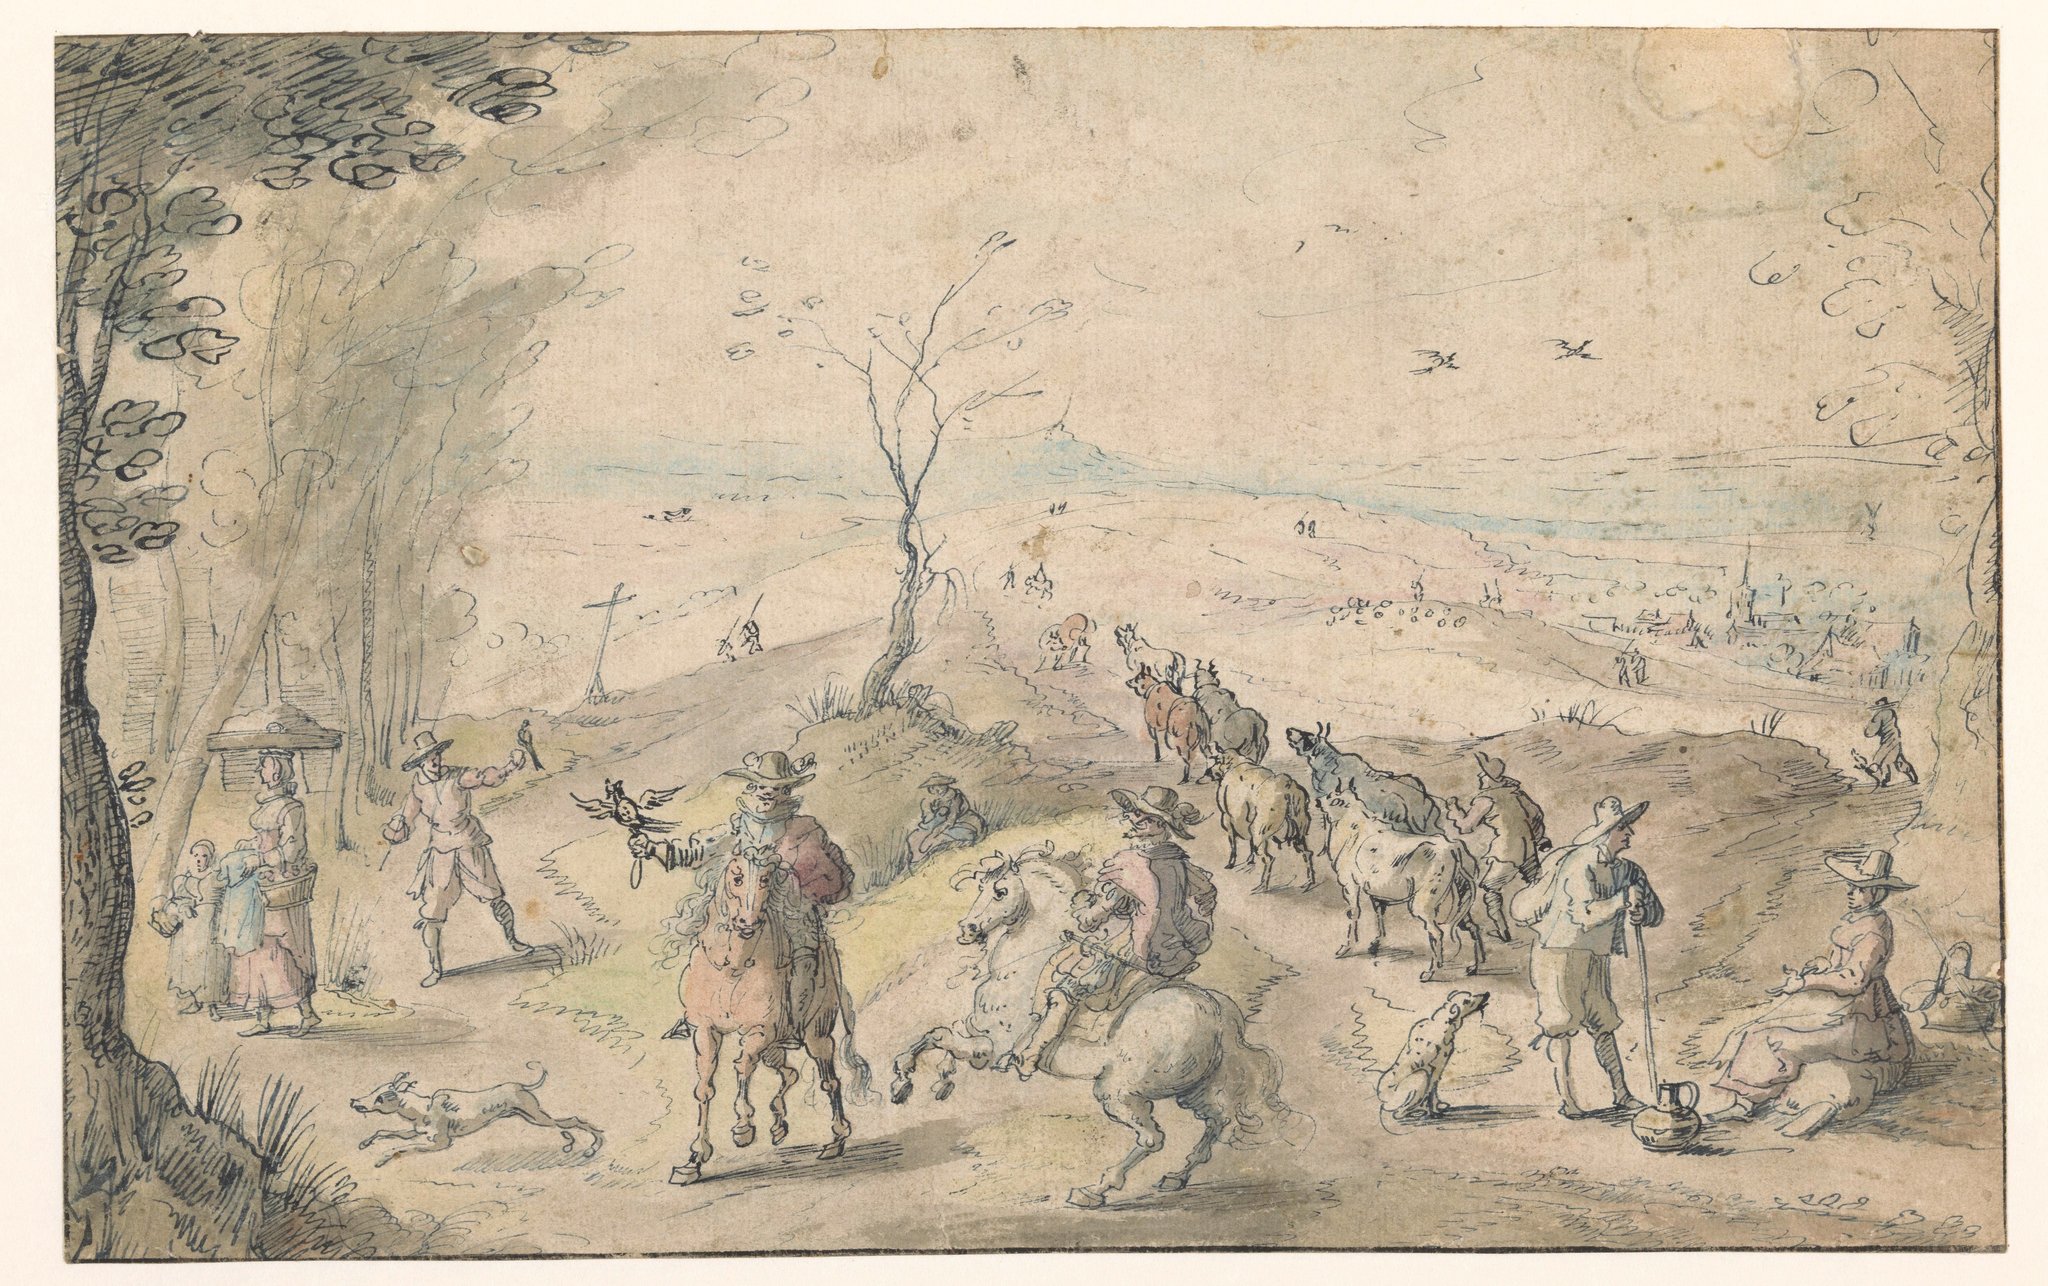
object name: watercolor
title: Landschap met valkeniers en veehoeder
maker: jan wildens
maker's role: draughtsman, painter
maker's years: 1585-1653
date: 1596-1653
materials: paper, watercolor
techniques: brush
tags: bird hunting (+ hunting with falcon, hawk; falconry)